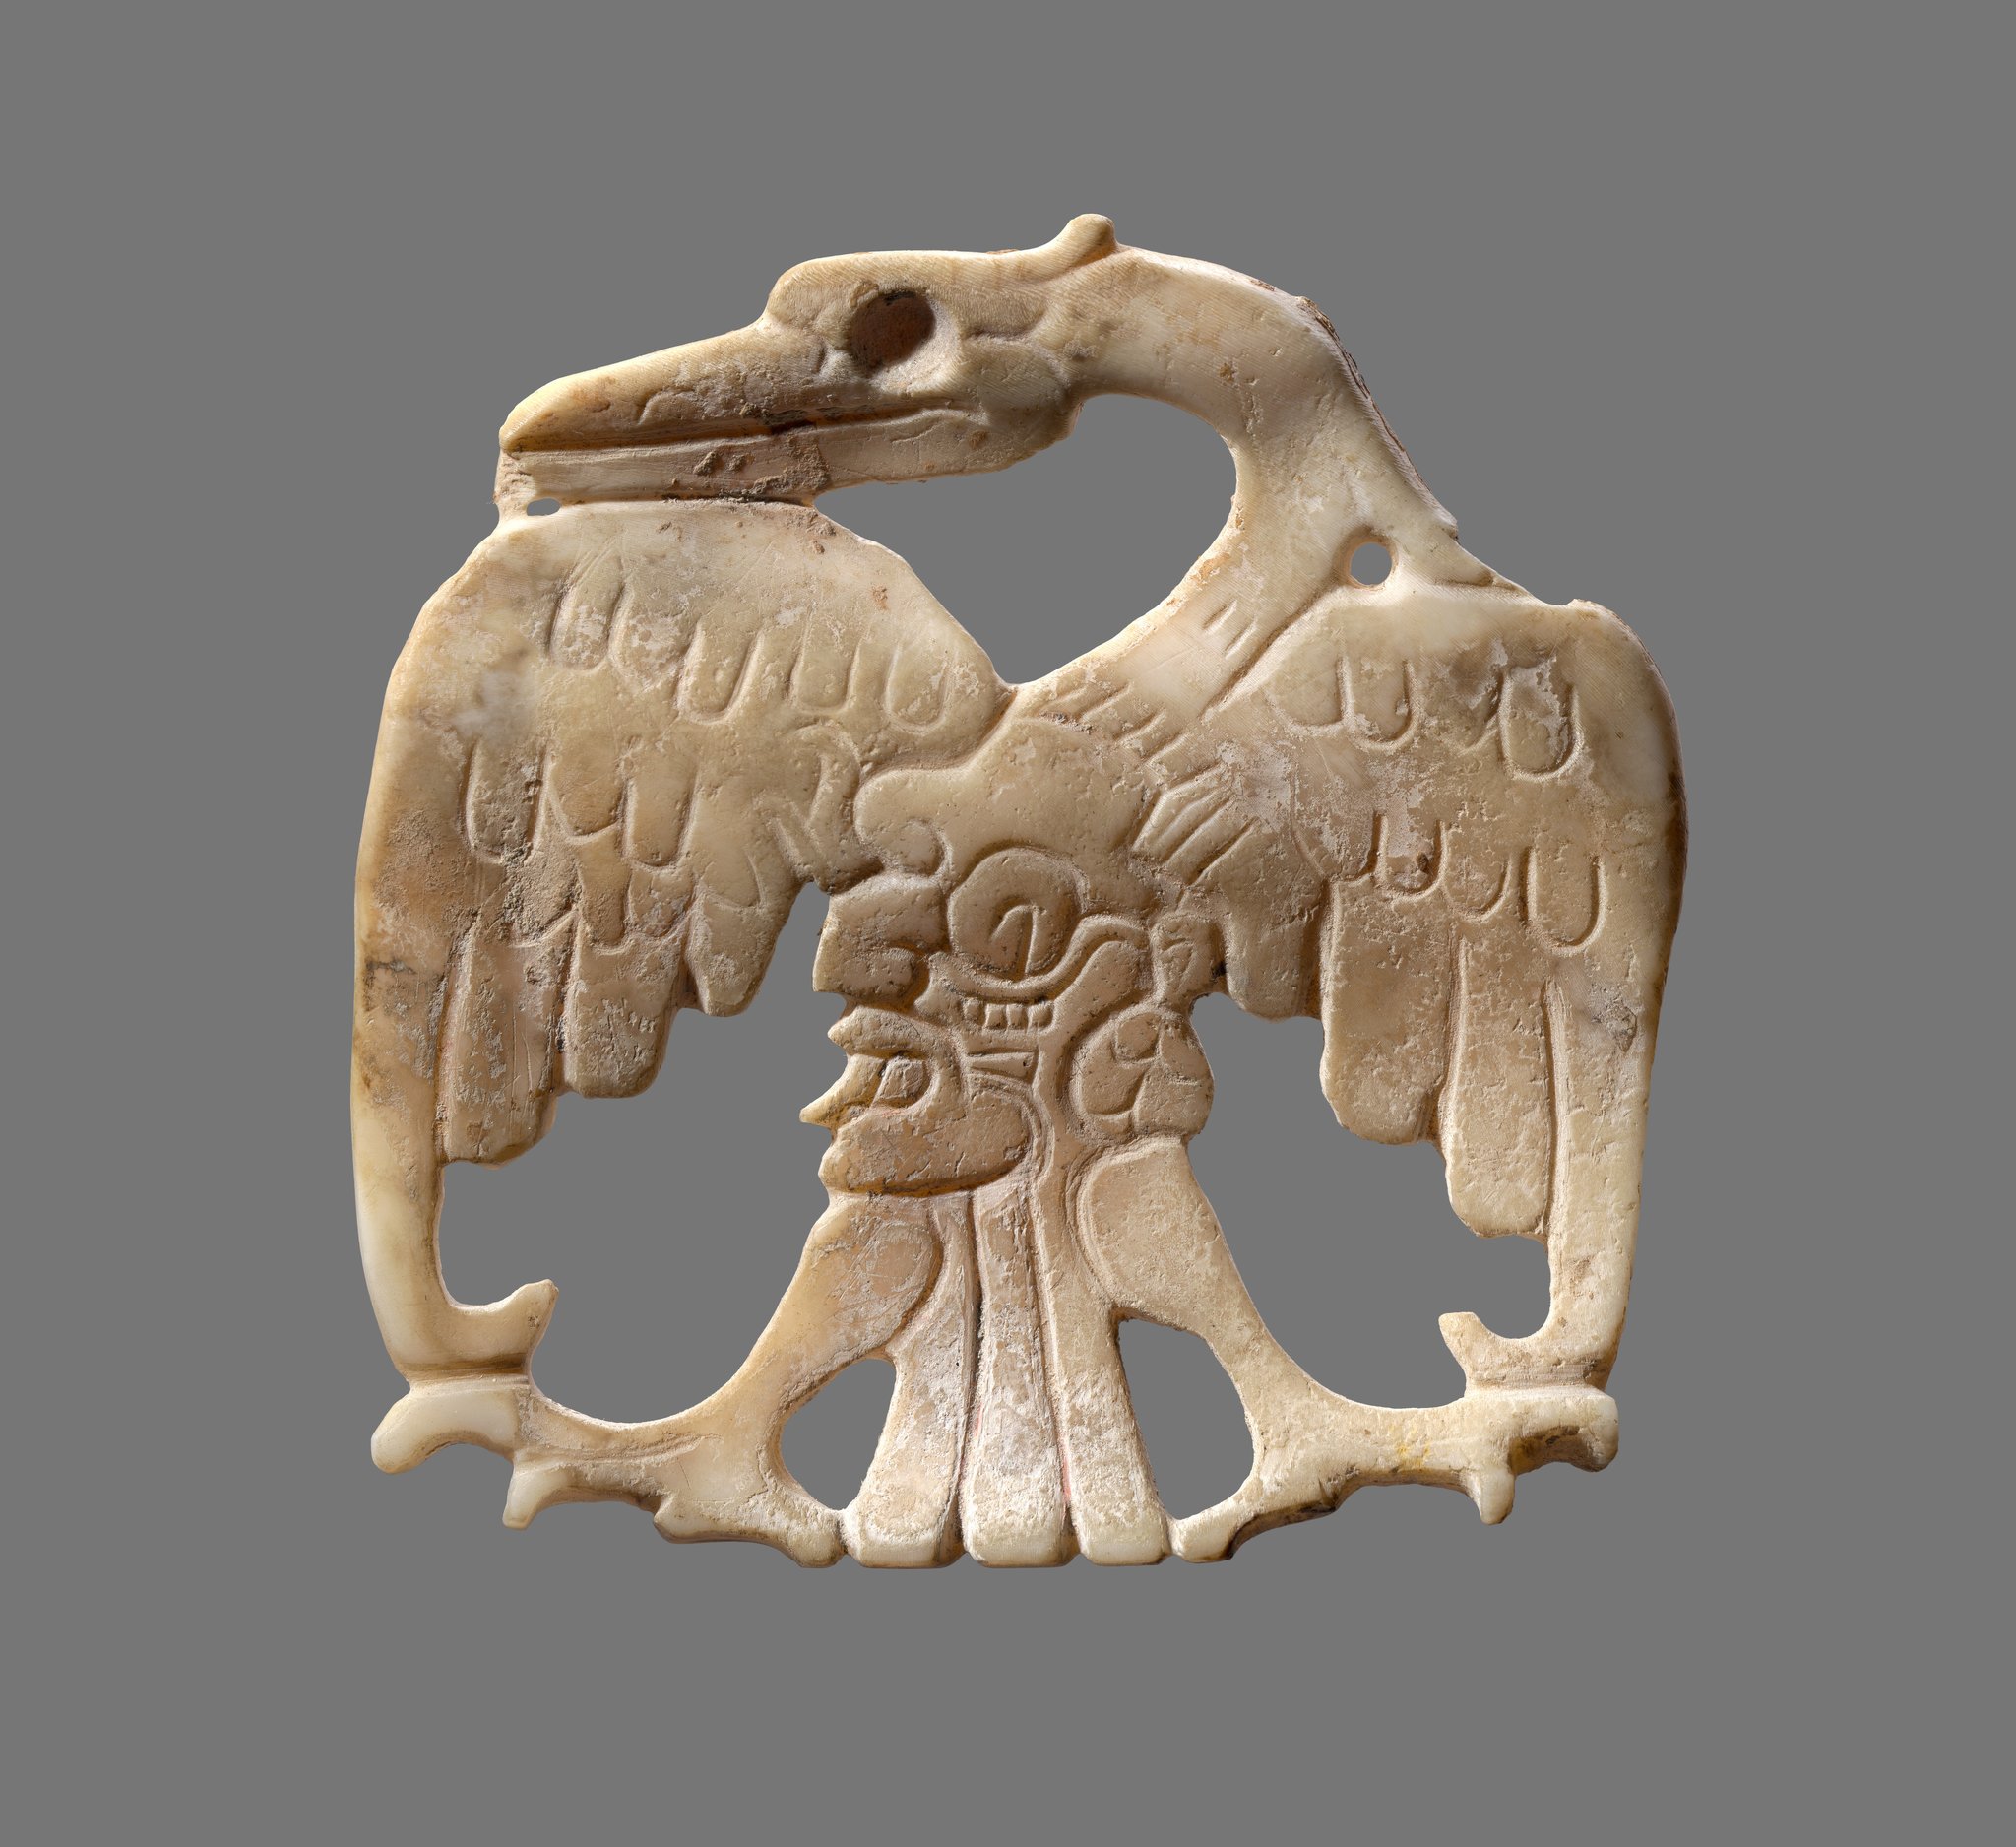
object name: ornament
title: Bird ornament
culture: maya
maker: maya artist(s)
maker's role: artist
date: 600-800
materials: shell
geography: guatemala or mexico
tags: birds